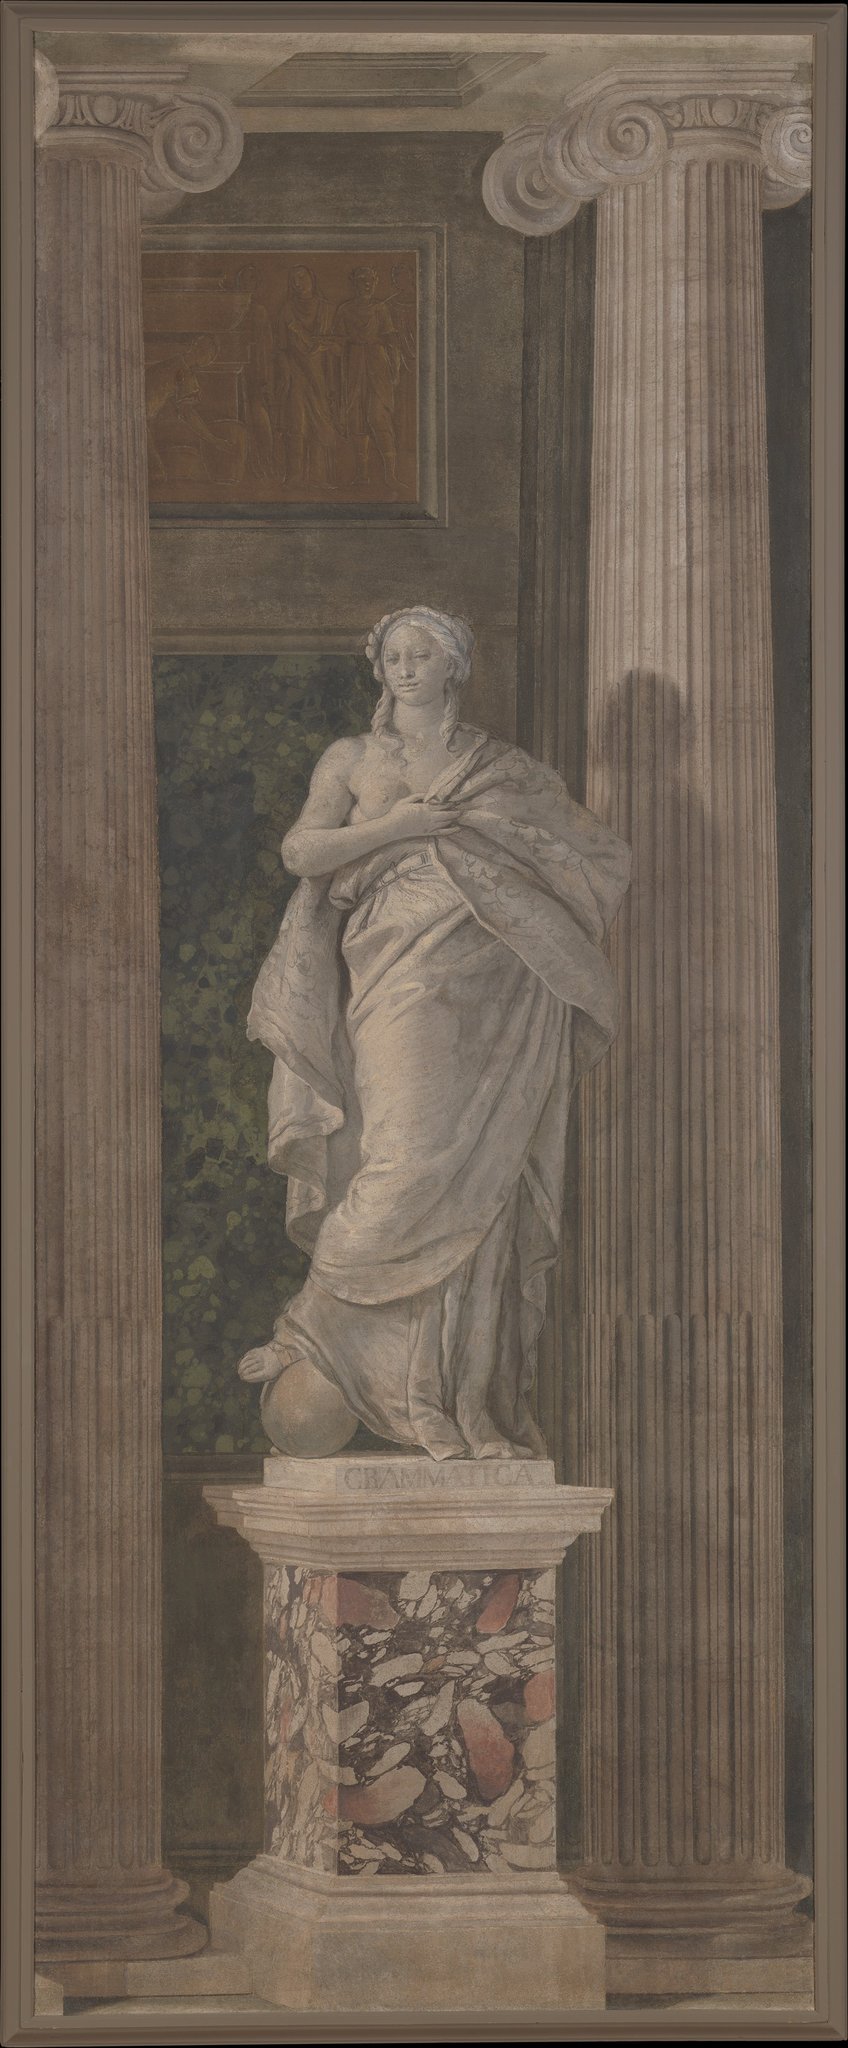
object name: painting, monochrome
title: Allegorical Figure Representing Grammar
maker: giovanni battista tiepolo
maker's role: artist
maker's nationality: italian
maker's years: 1696-1770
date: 1760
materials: canvas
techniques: fresco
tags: women